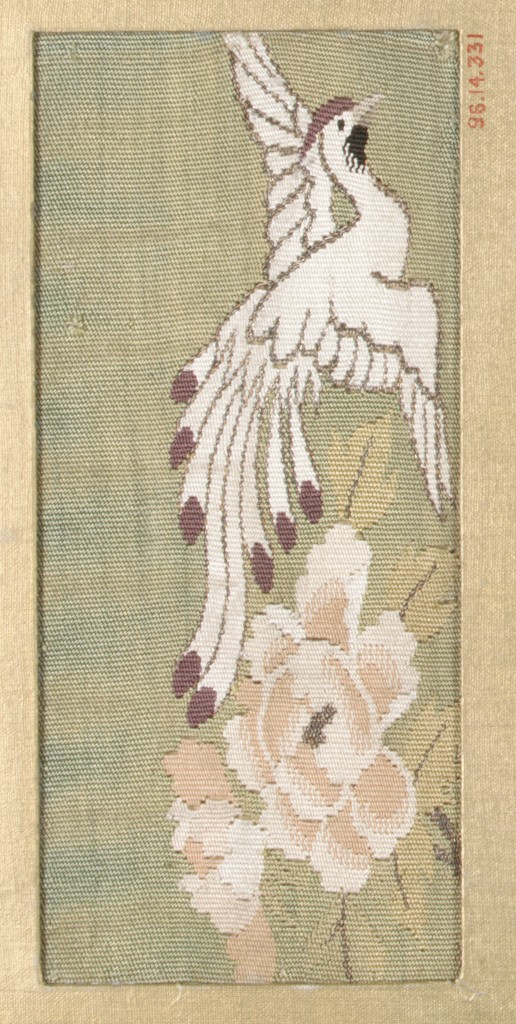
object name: piece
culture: japanese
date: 1701-1900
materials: silk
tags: flowers